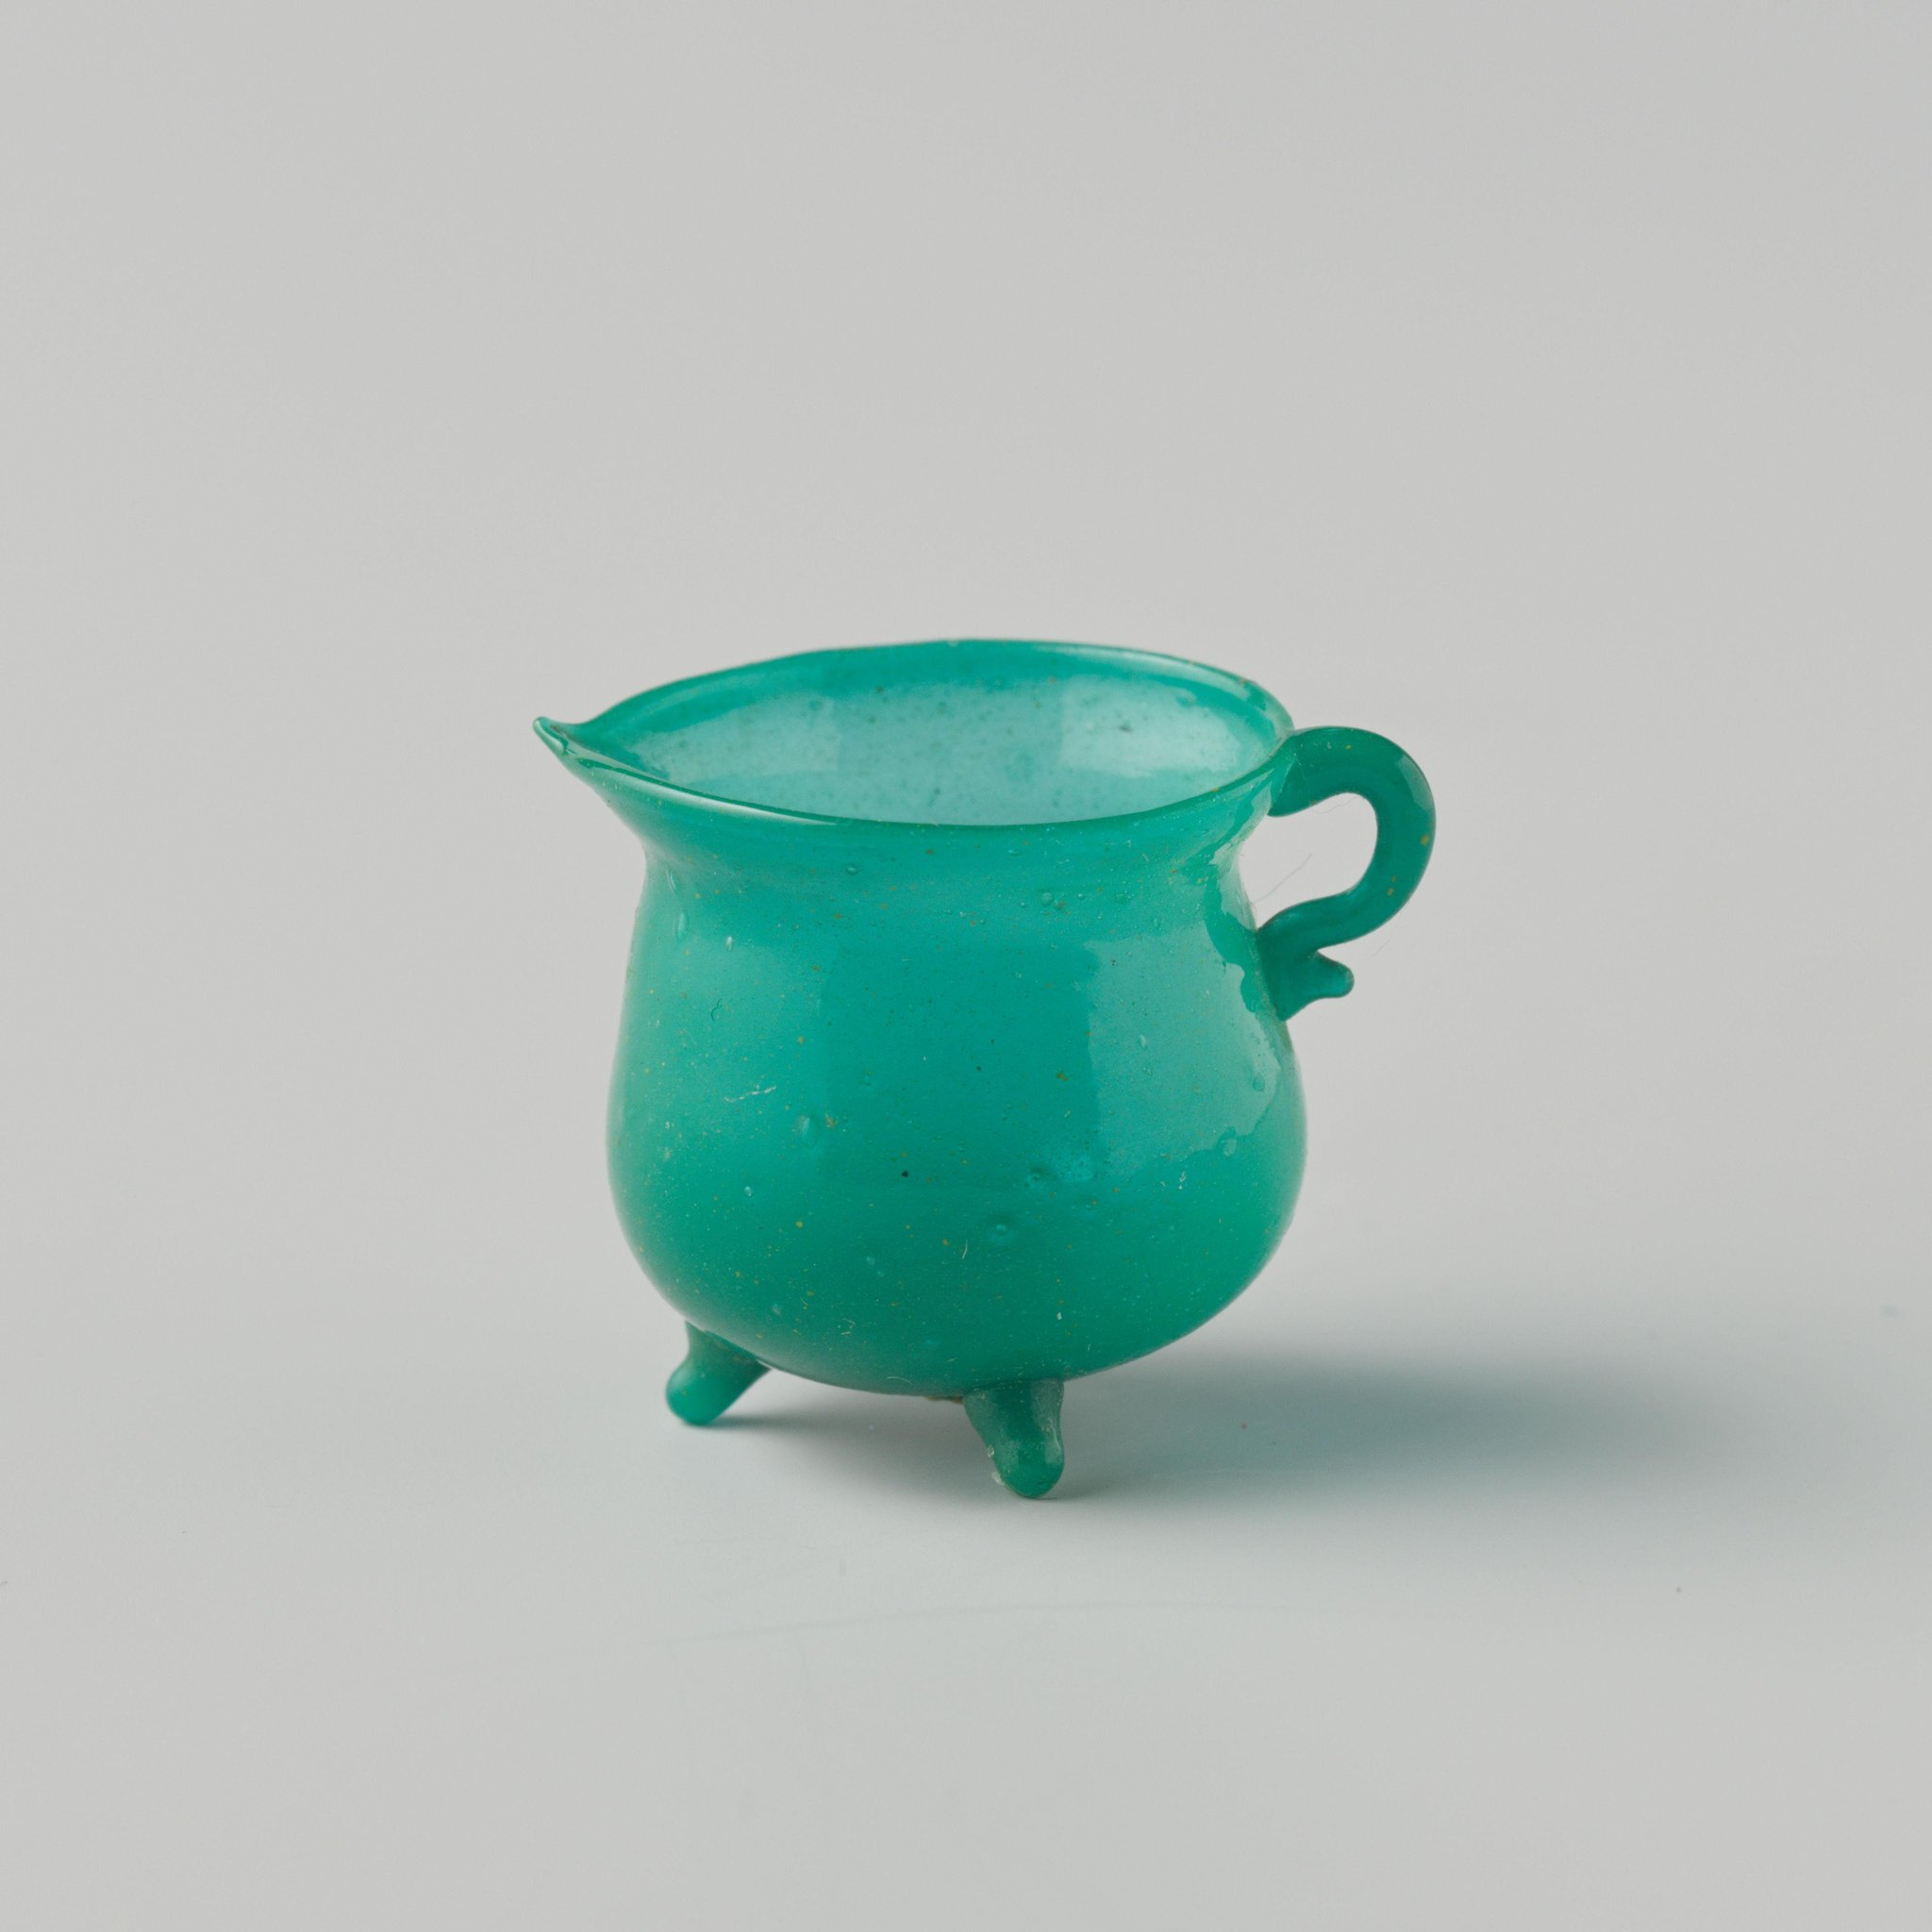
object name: cauldron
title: Kookkan van opaak groen glas (waarschijnlijk imitatie groen aardewerk); op drie pootjes, met schenklip en oor.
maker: Anonymous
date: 1675-1710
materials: glass